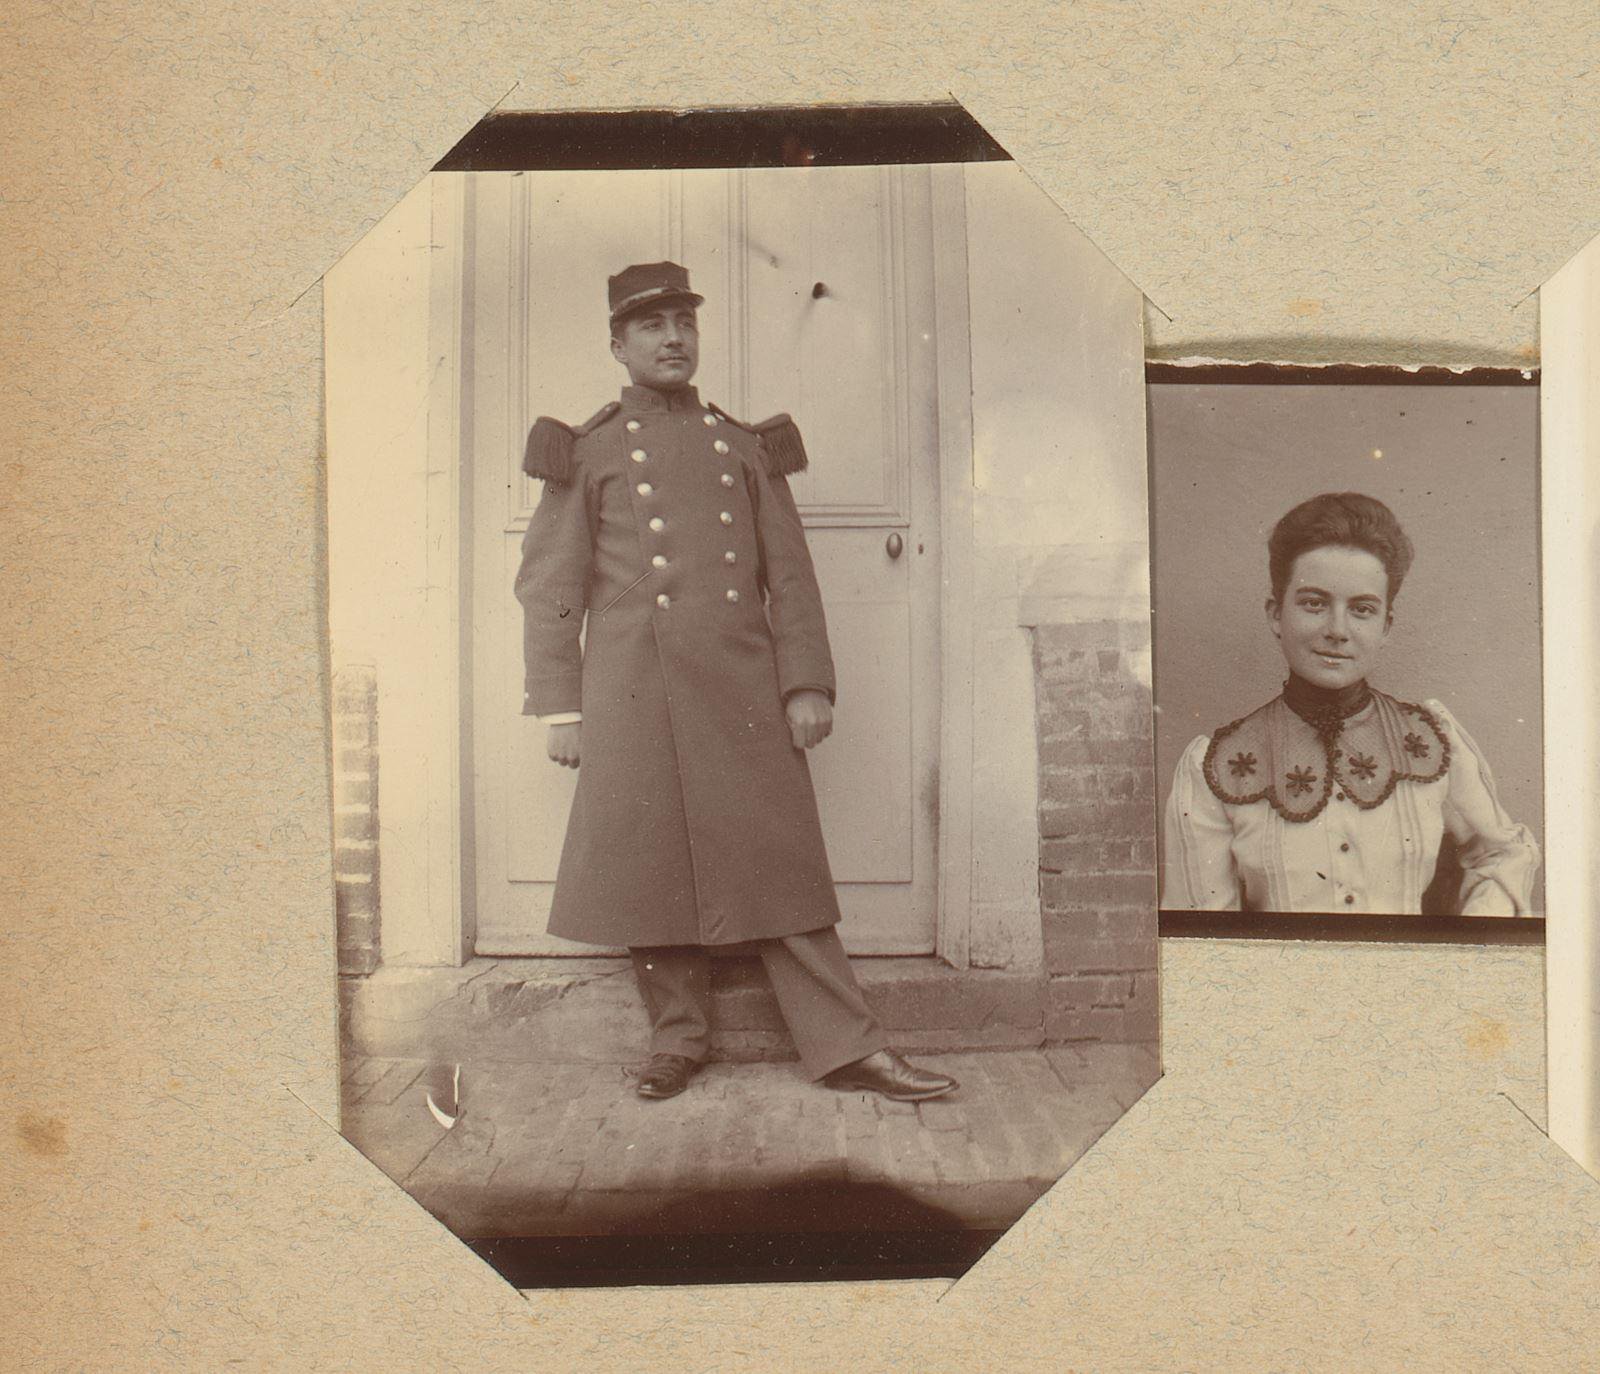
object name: photograph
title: Portret van een man in militair uniform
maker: Anonymous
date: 1897-1900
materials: paper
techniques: gelatin silver print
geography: france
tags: adult man, historical persons, (military) uniforms, france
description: Over de foto is een ander negatief afgedrukt van een voorstelling van bomen.